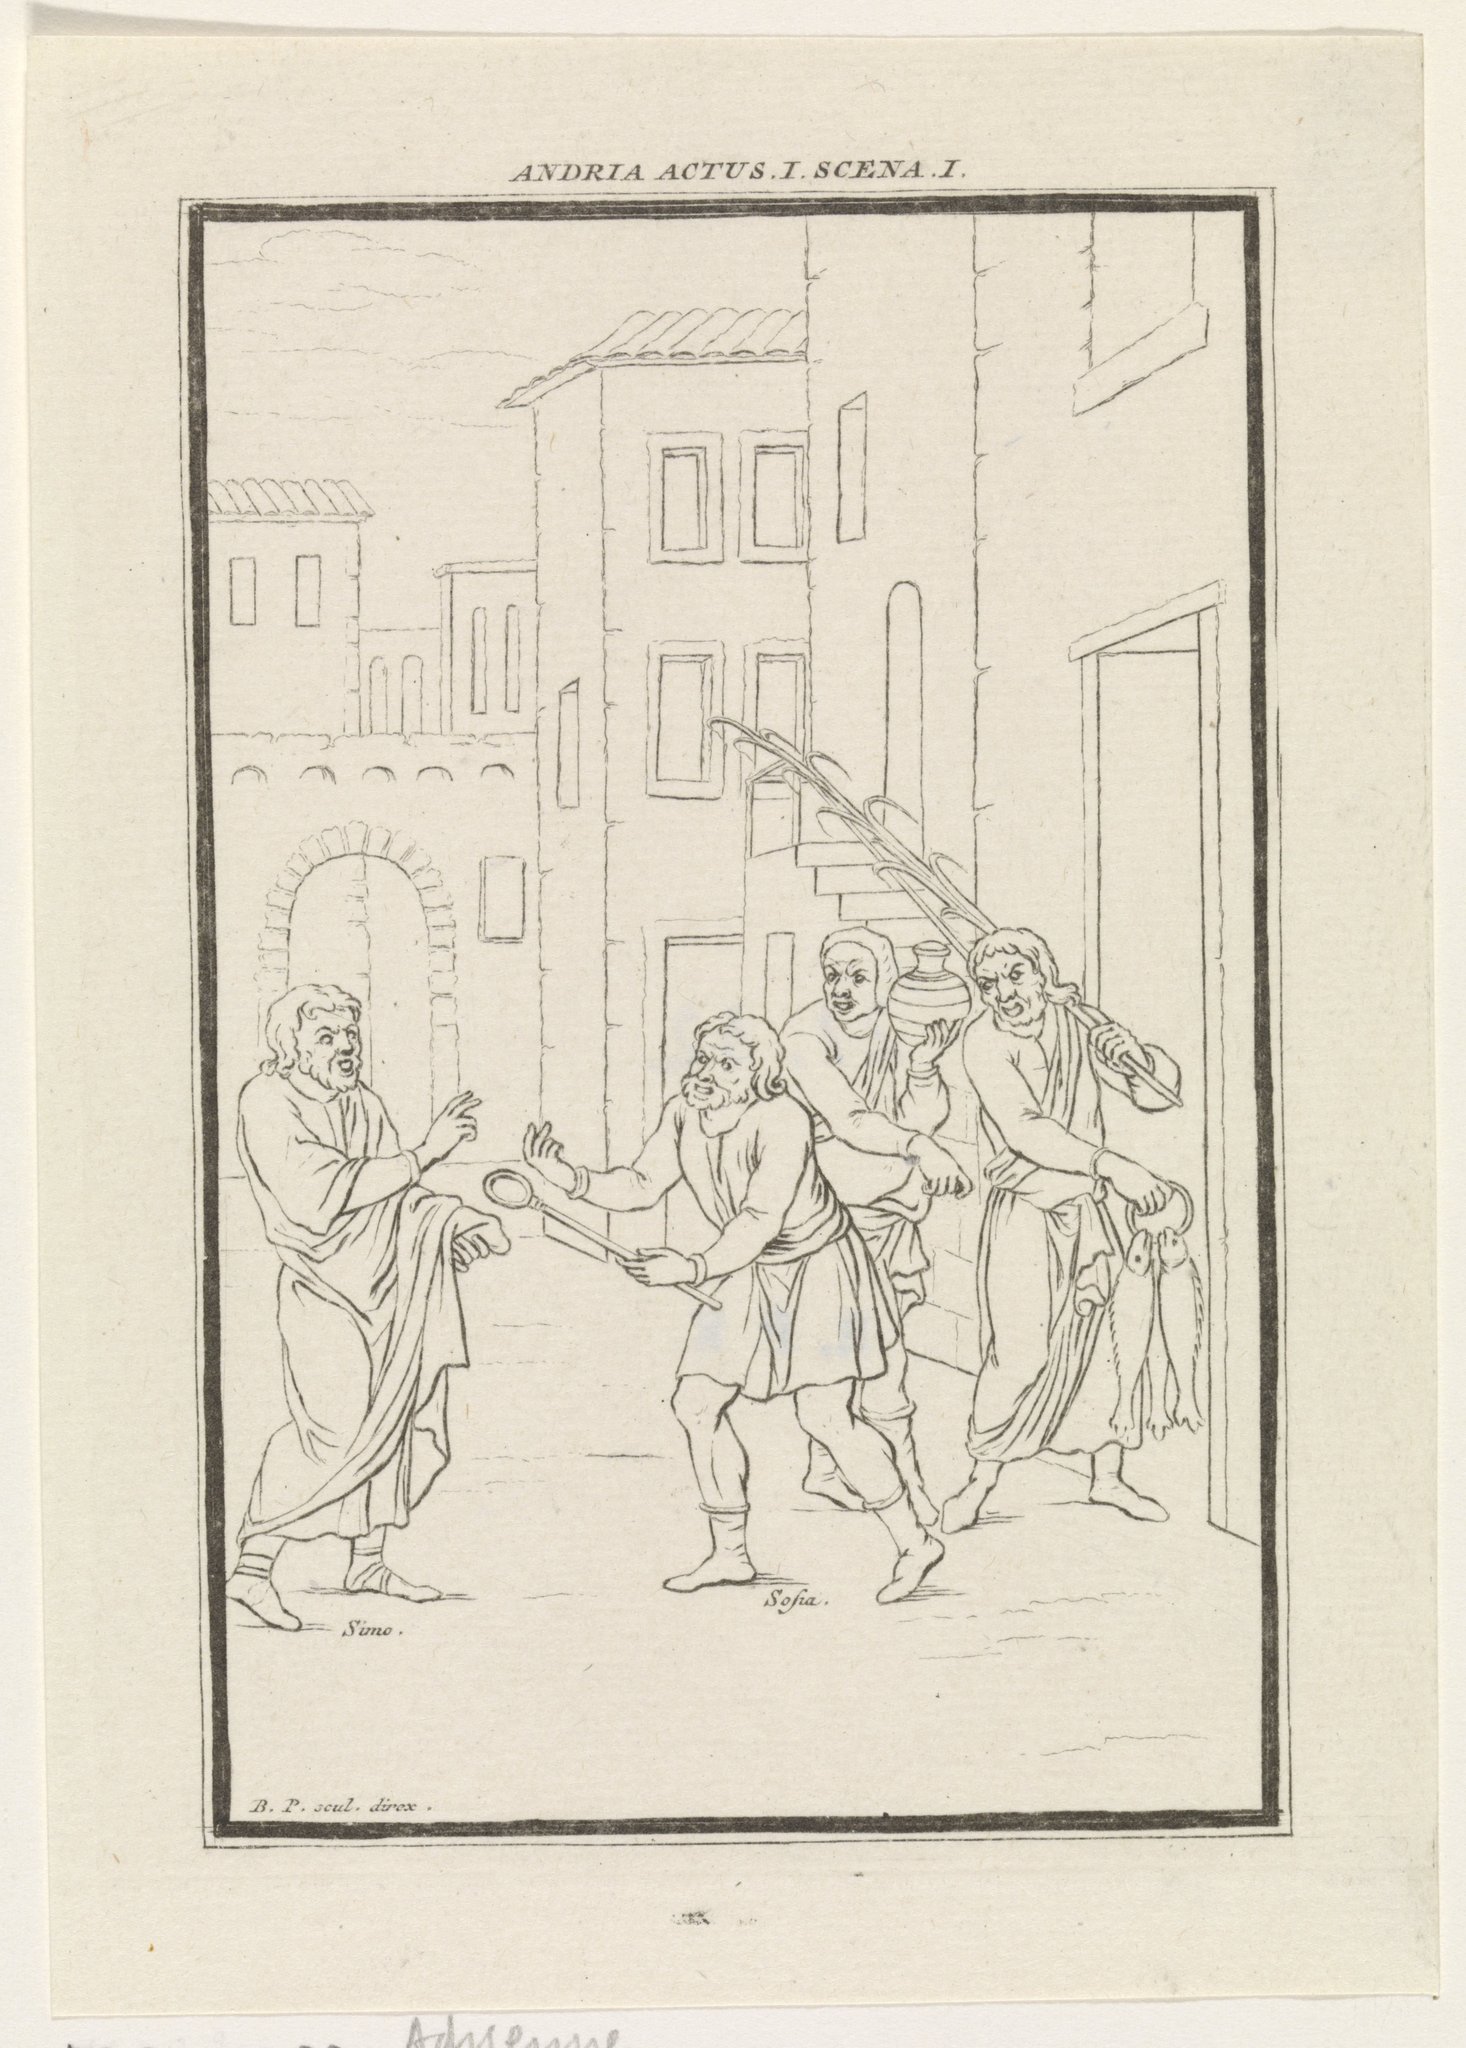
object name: book illustration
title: Scène uit de komedie Andria van Terentius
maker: bernard picart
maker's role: draughtsman, print maker, publisher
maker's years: 1673-1733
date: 1716-1718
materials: paper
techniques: engraving, etching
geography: amsterdam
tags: specific works of literature, house personnel, servants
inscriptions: collector's mark: Lugt 2233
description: Prent ook gebruikt als illustratie in: Terentius, Publius. Les comedies de Terence: avec la traduction et les remarques, deel I, na p. 18. [Geannoteerd door] Anne Dacier. Rotterdam: Caspar Fritsch, 1717.